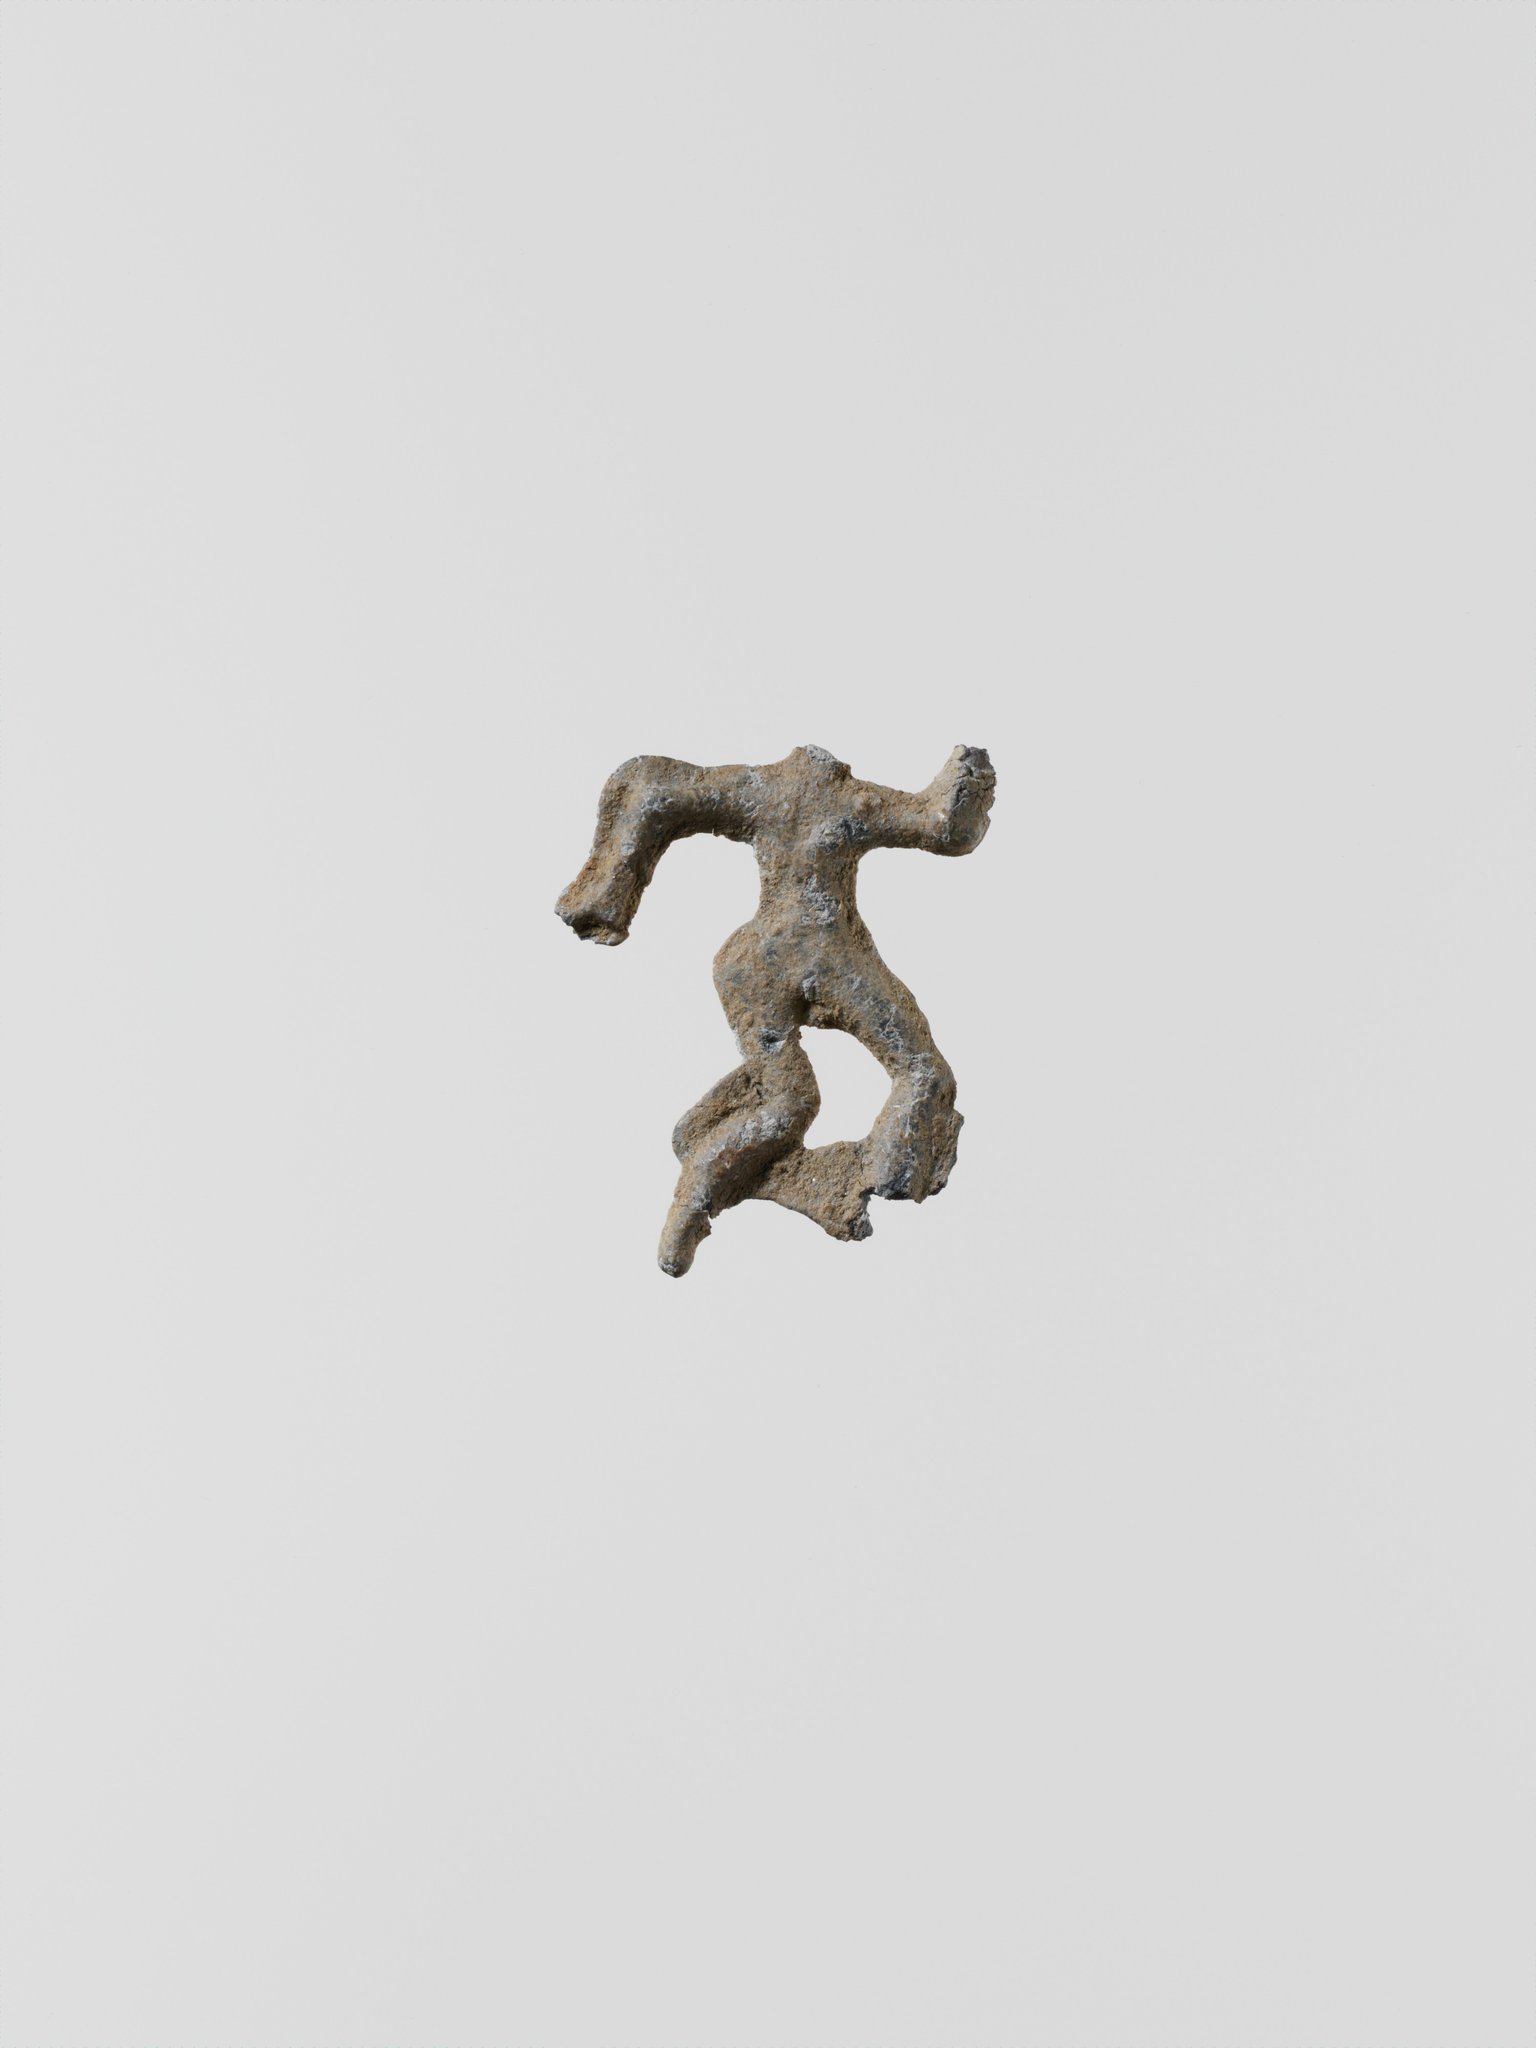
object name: statuette of a runner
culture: greek, laconian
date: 7000-30 BCE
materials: lead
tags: human figures,running